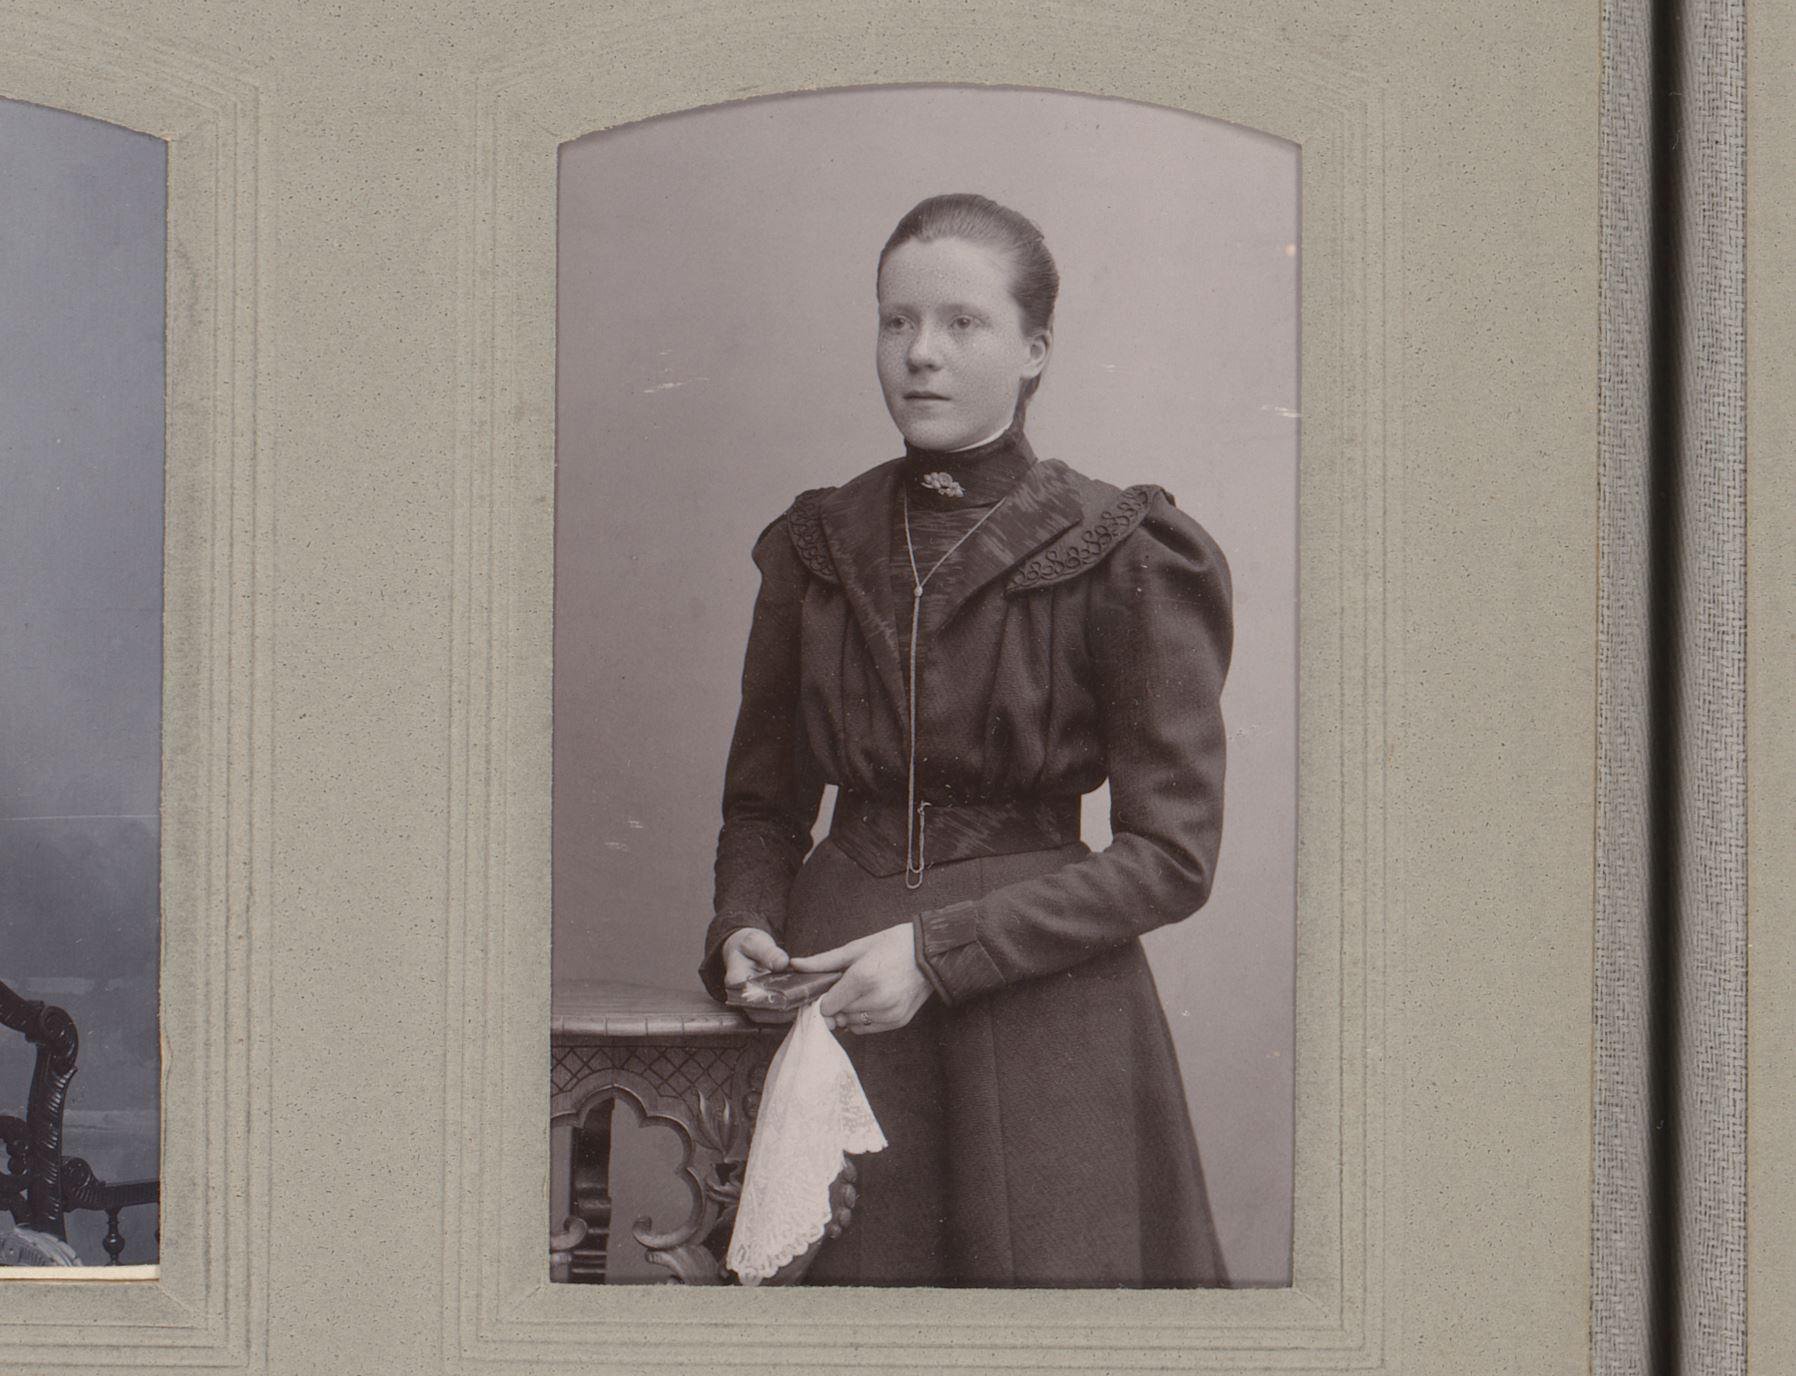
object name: photograph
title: Portret van een staande jonge vrouw met boek en witte zakdoek in de hand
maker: landén larsson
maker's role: fotograaf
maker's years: 1866-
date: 1900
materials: cardboard, photographic support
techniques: collodion silver print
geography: stockholm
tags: adolescent, young woman, maiden, historical persons - bb - woman, handkerchief, book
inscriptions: inscription: ‘KONGL. HOF-FOTOGRAF./ Allm. Telef./ 107 13./ L. Larsson/ Humlegårdsgatan/ 21/ STOCKHOLM’, date: ‘1900’